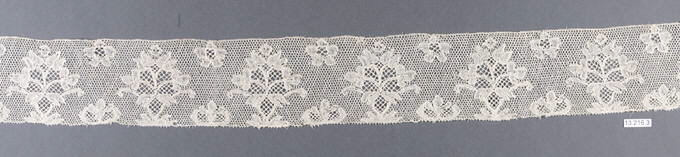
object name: border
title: Lace border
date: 1701-1800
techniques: lace